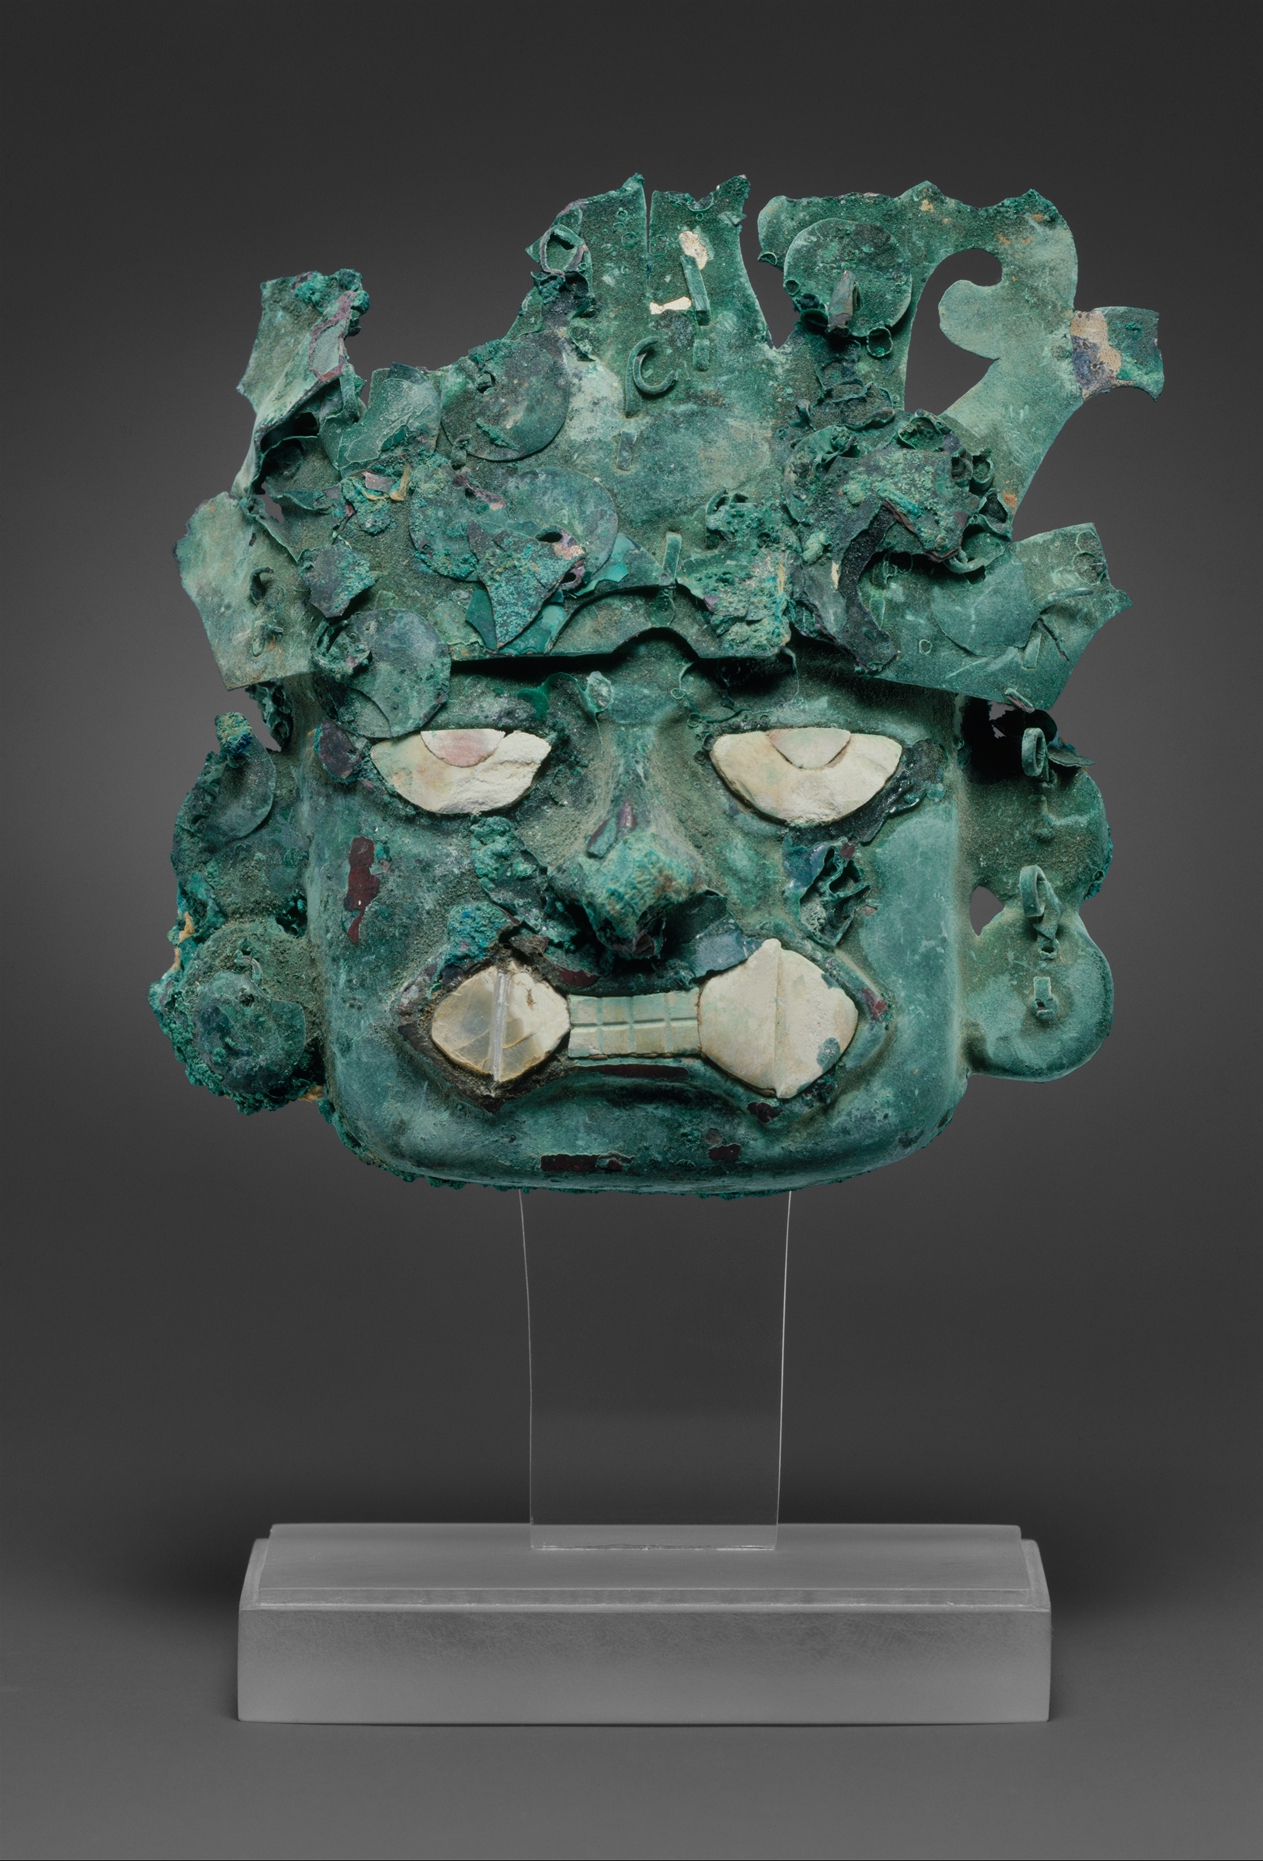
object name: ornament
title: Ornamental mask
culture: moche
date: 501-700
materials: shell, metal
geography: peru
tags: faces